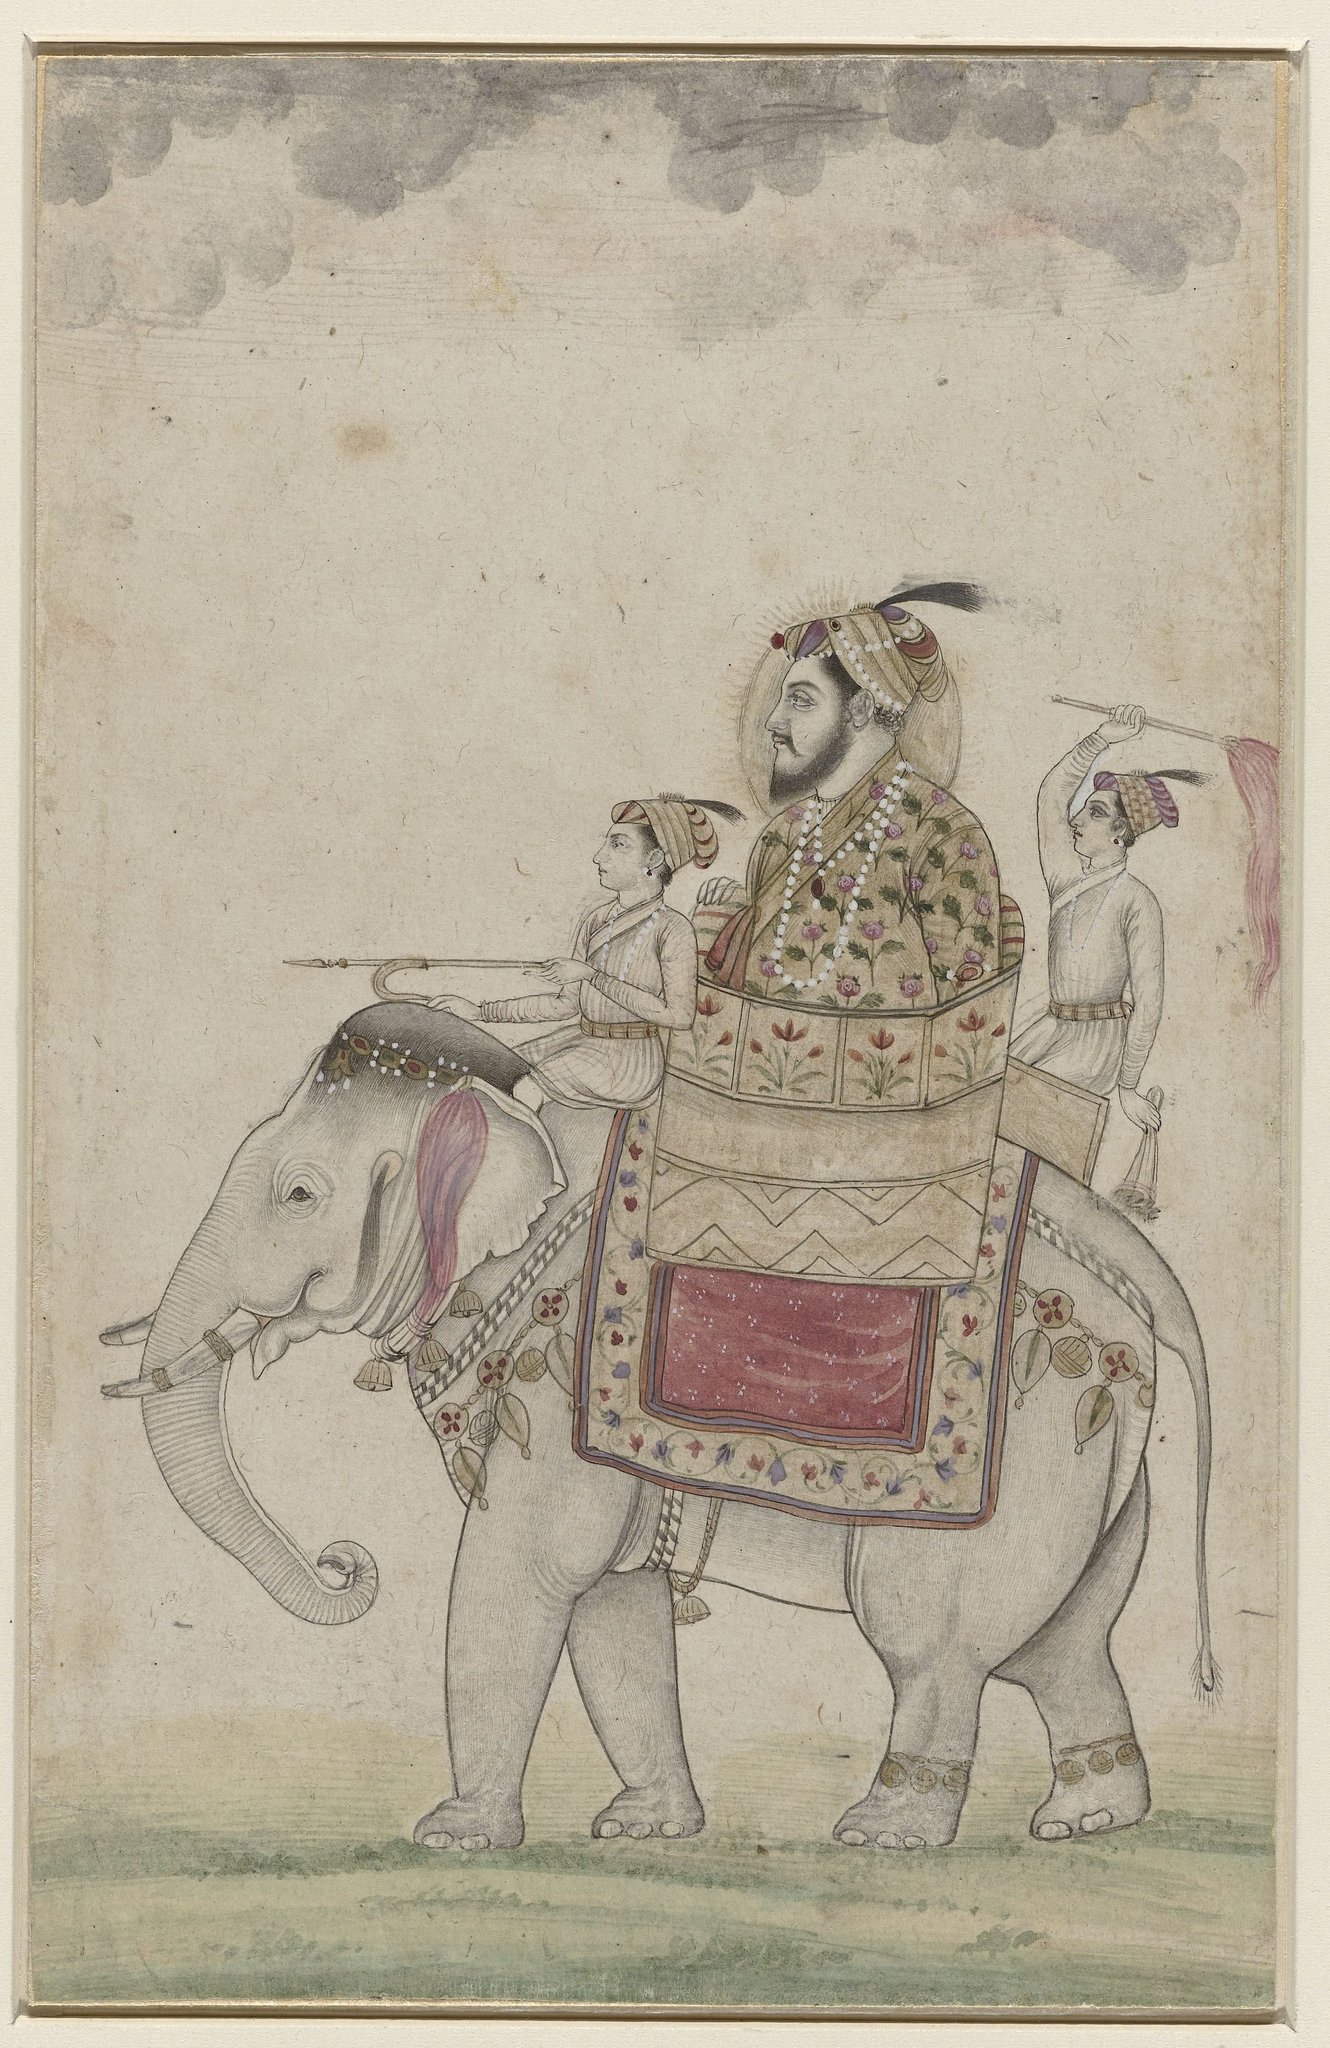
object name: indian miniature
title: Mughal prins zittend op een olifant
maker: Anonymous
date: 1675-1700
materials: paint, paper, watercolor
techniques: brush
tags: trunked animals: elephant